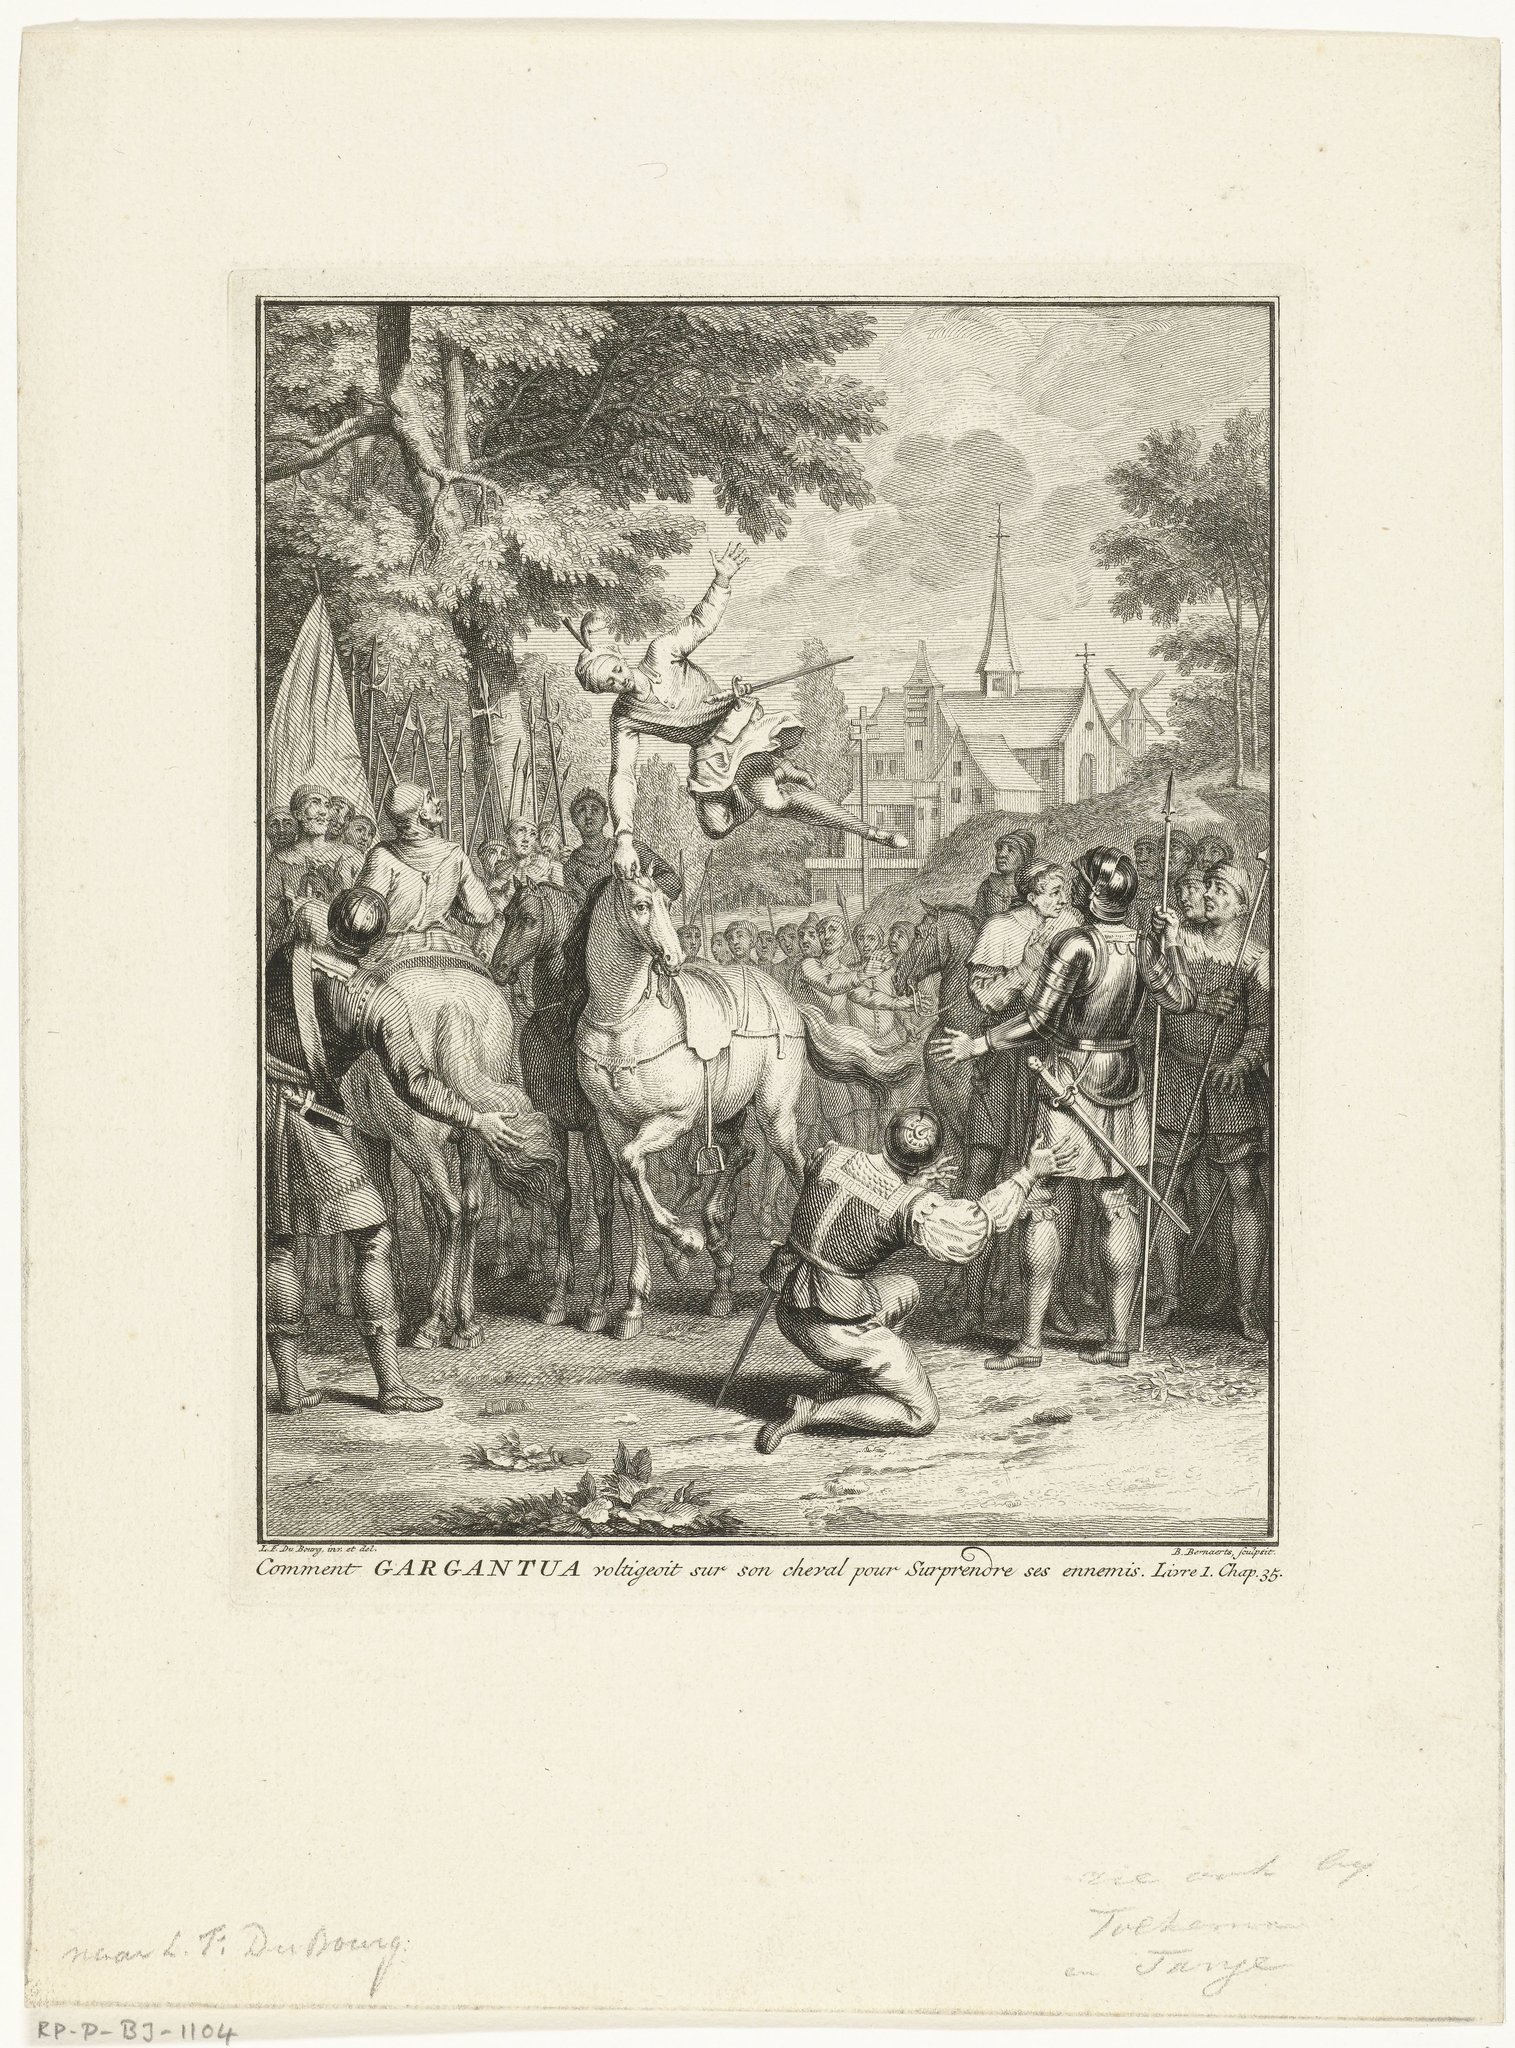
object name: print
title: Gargantua op zijn paard voltigerend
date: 1741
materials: paper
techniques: engraving, etching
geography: amsterdam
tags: (scenes from) specific works of literature (with author, title), riding-school, manège (+ unusual way of sitting on riding-animal)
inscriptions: collector's mark: Lugt 240, collector's mark: Lugt 2228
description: De reus Gargantua voltigeert op zijn paard. De toekijkende soldaten en ridders zijn onder de indruk van zijn kunst.